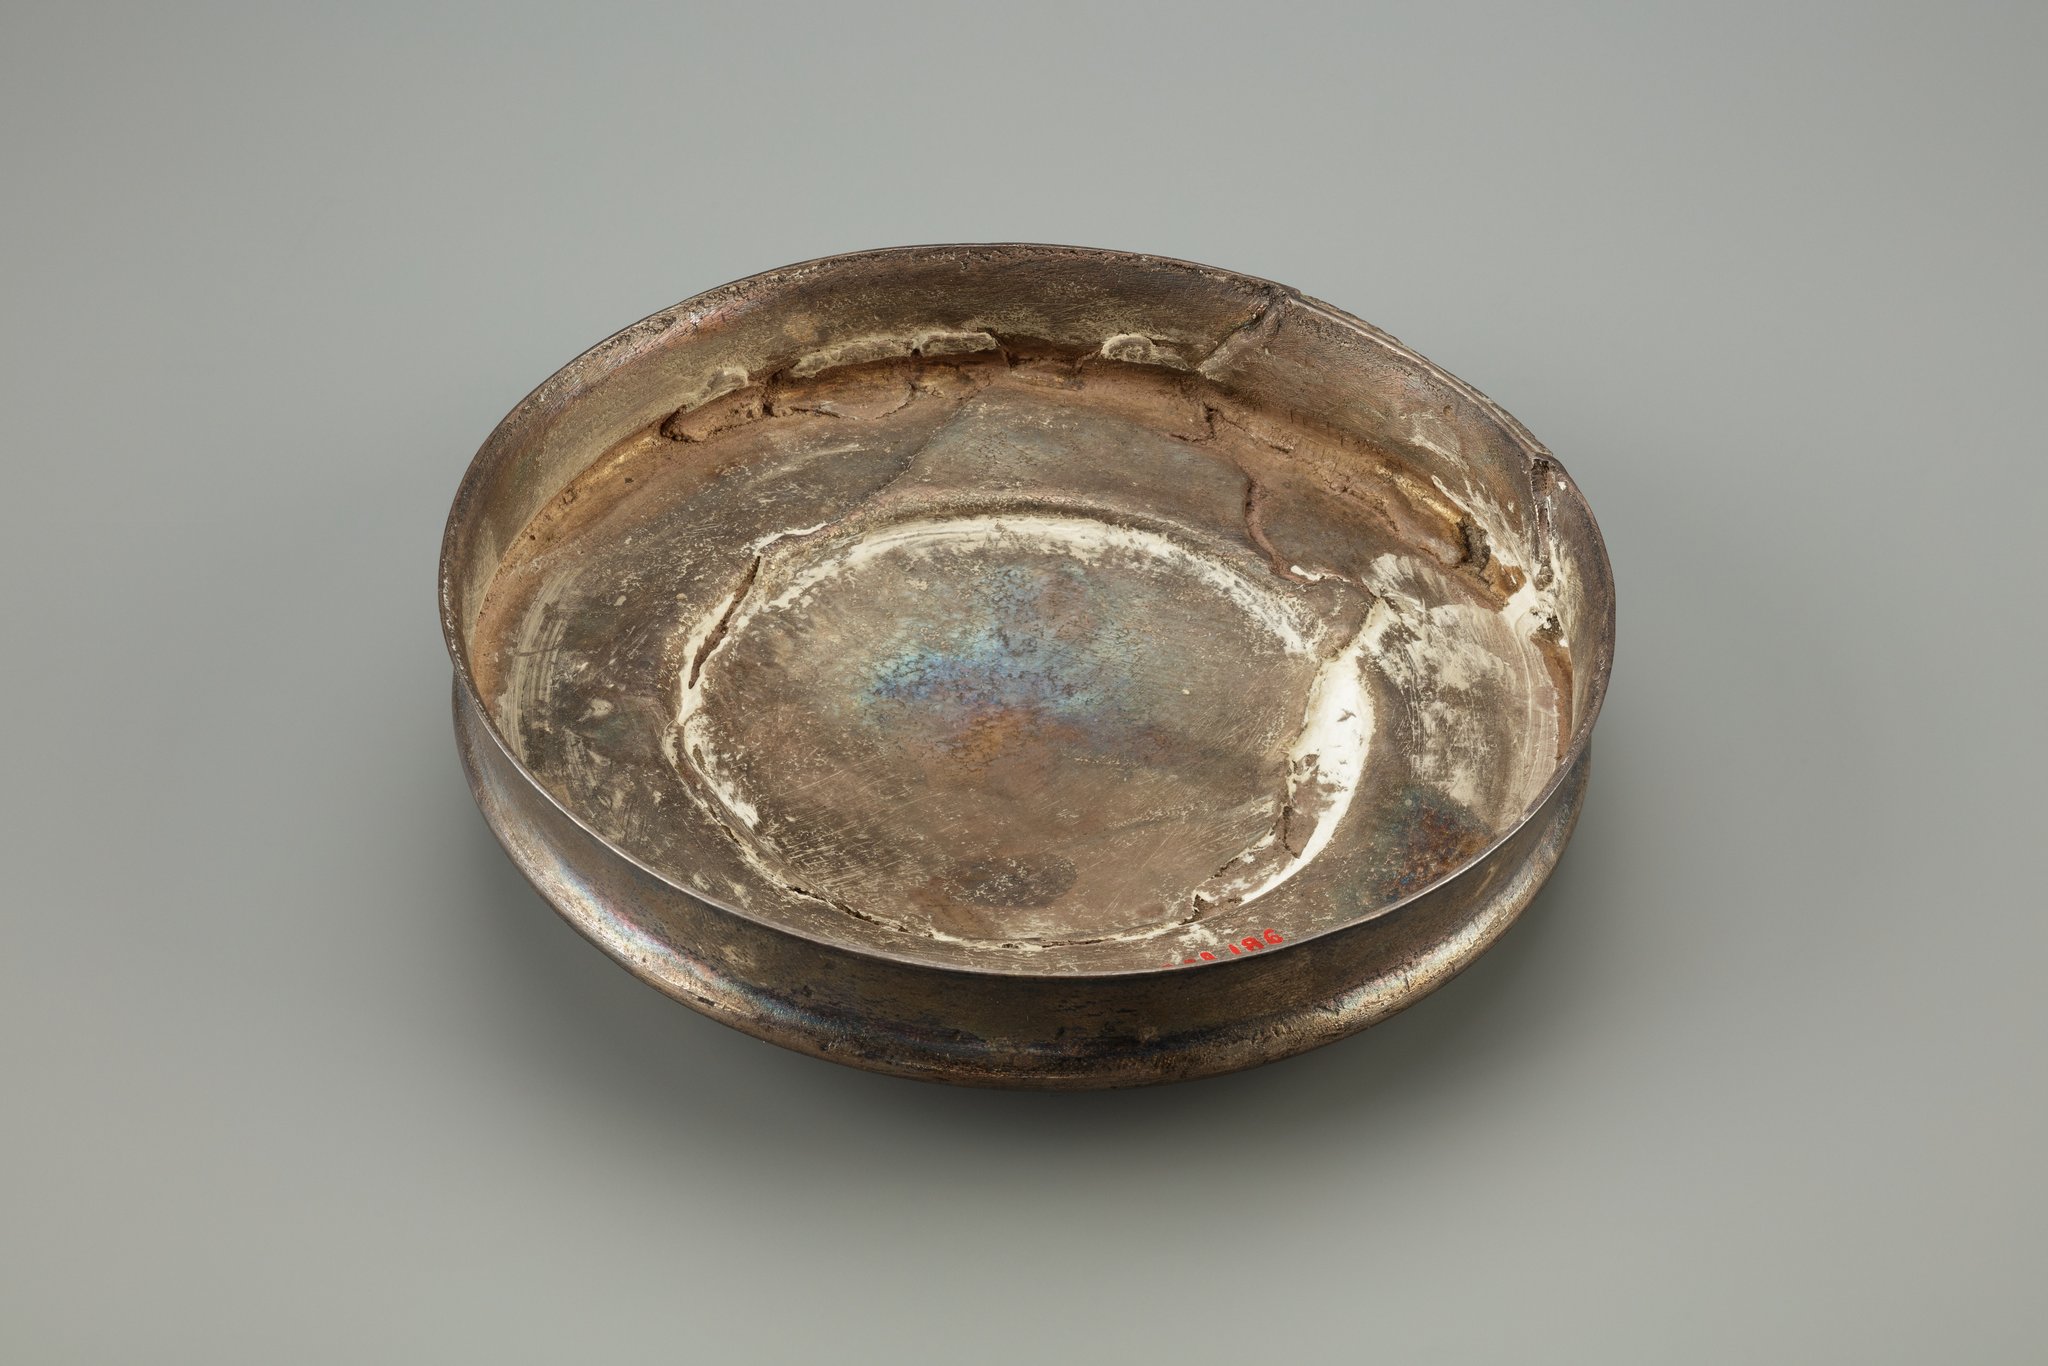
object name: strainer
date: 1279-1213 BCE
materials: silver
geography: egypt